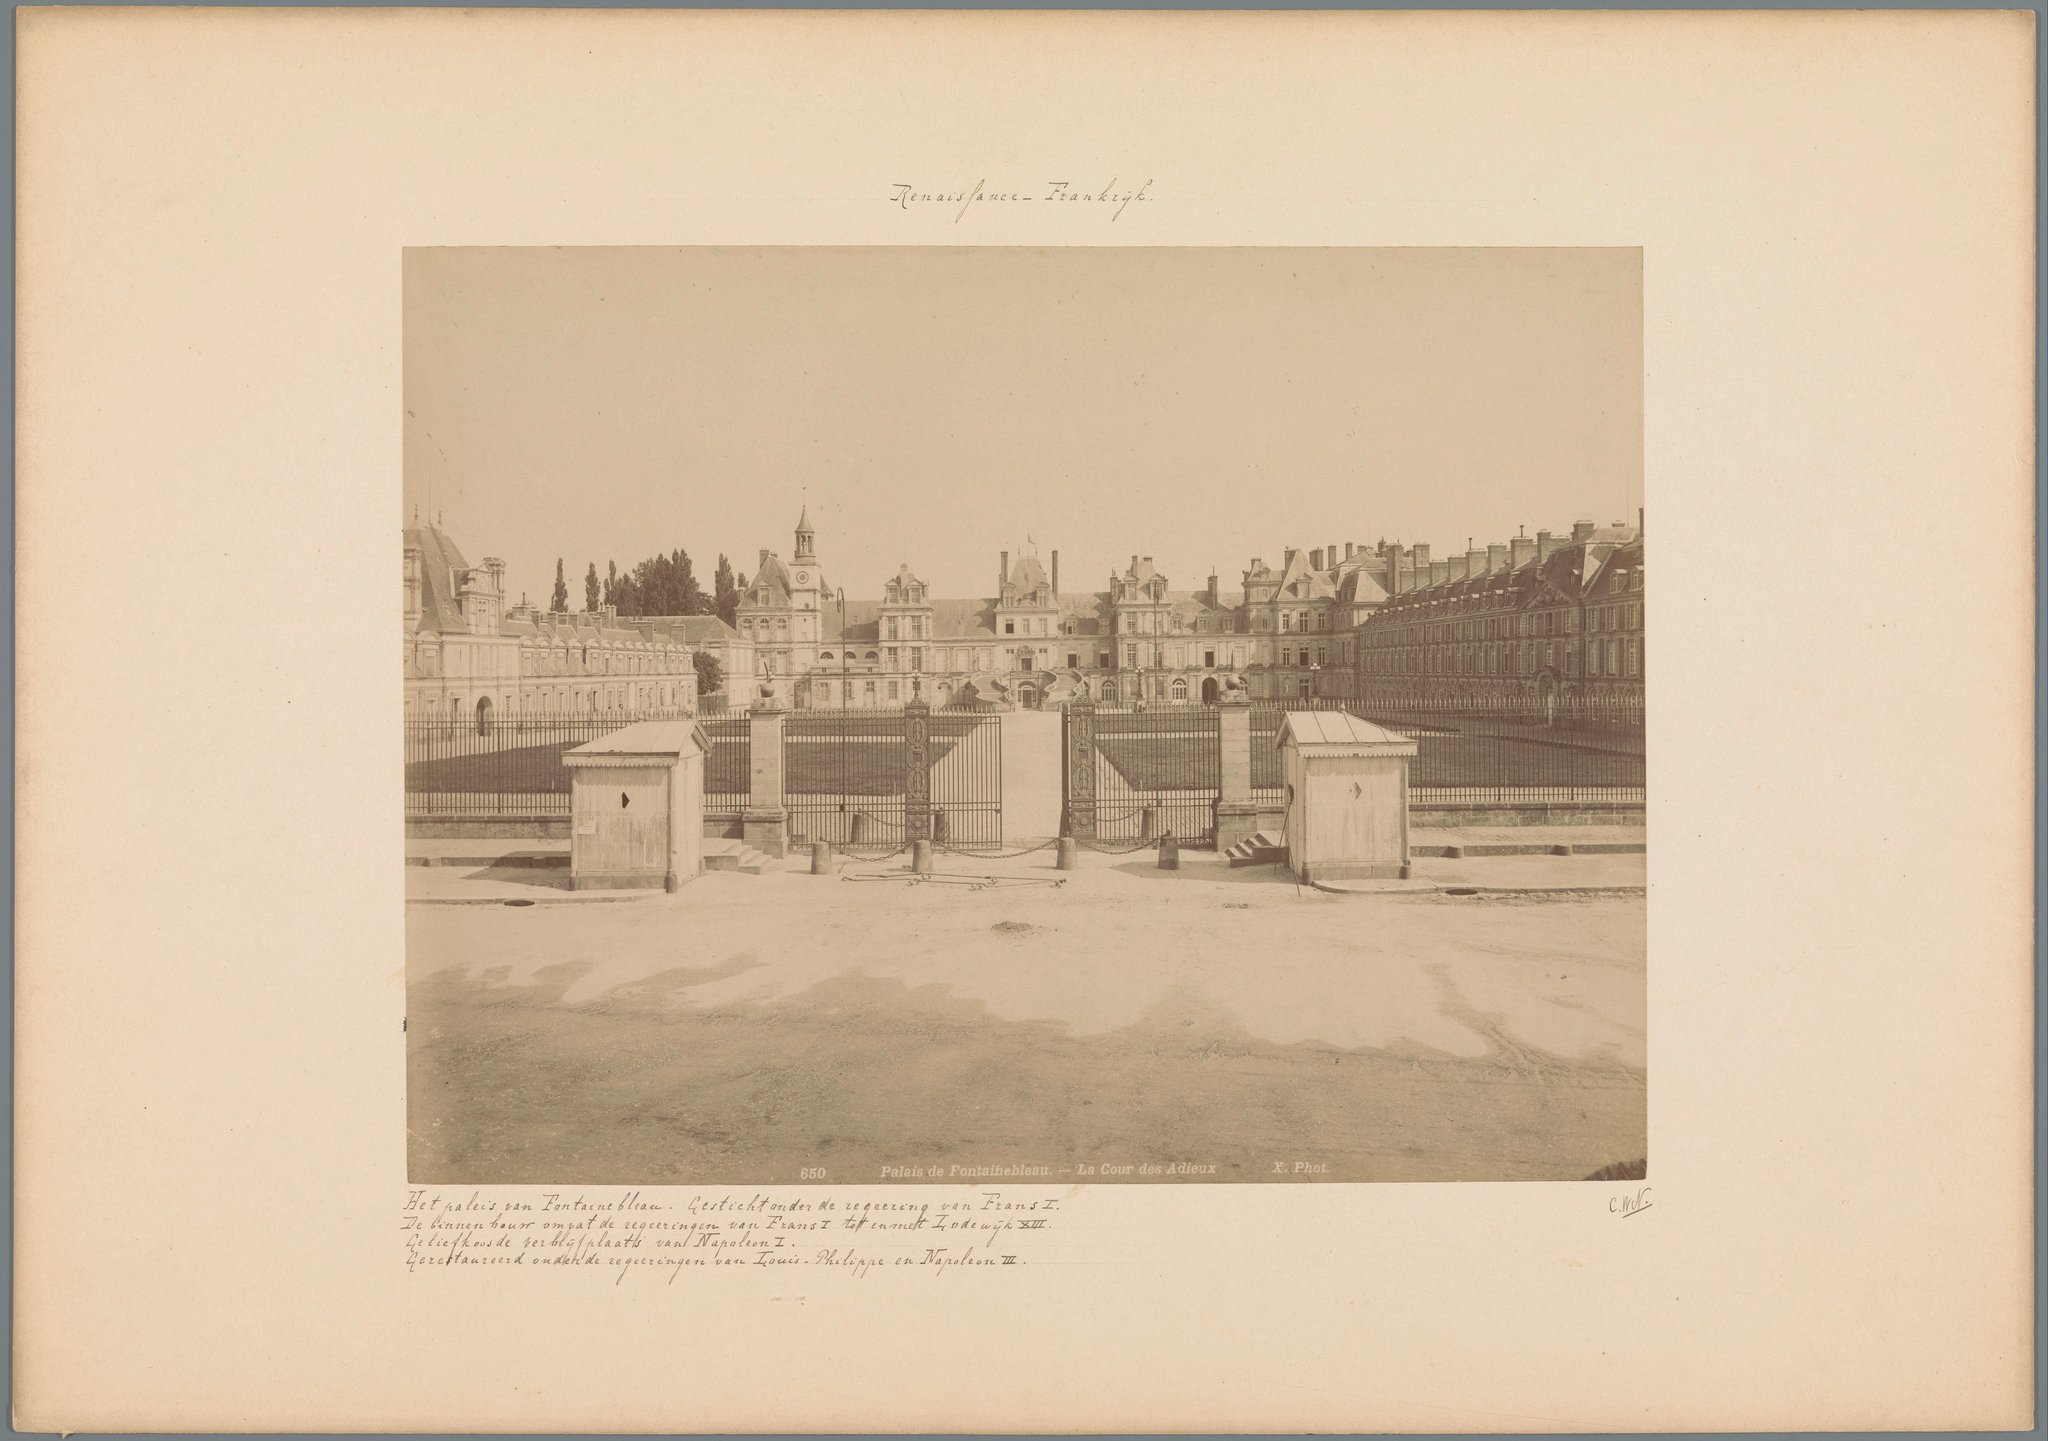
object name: photograph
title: Palais de Fontainebleau. - La Cour des Adieux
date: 1875-1900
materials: cardboard, photographic support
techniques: albumen print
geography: fontainebleau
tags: fence, wall, paling, palace, façade (of house or building), inner court of palace or 'hôtel'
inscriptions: number: ‘650’, collector's mark: ‘INSTITUUT VOOR KUNST- NIJVERHEIDSONDERWIJS GABRIËL METSUSTRAAT No. 16. AMSTERDAM’, inscription: ‘CWN.’, collector's mark: ‘KUNSTNIJVERHEIDSCHOOL QUELLINUS AMSTERDAM FRANS HALSSTRAAT 14.’, inscription: ‘Renaissance - Frankrijk. Het paleis van Fontainebleau (...) Gerestaureerd onder de regeringen van Louis-Philippe en Napoleon III.’